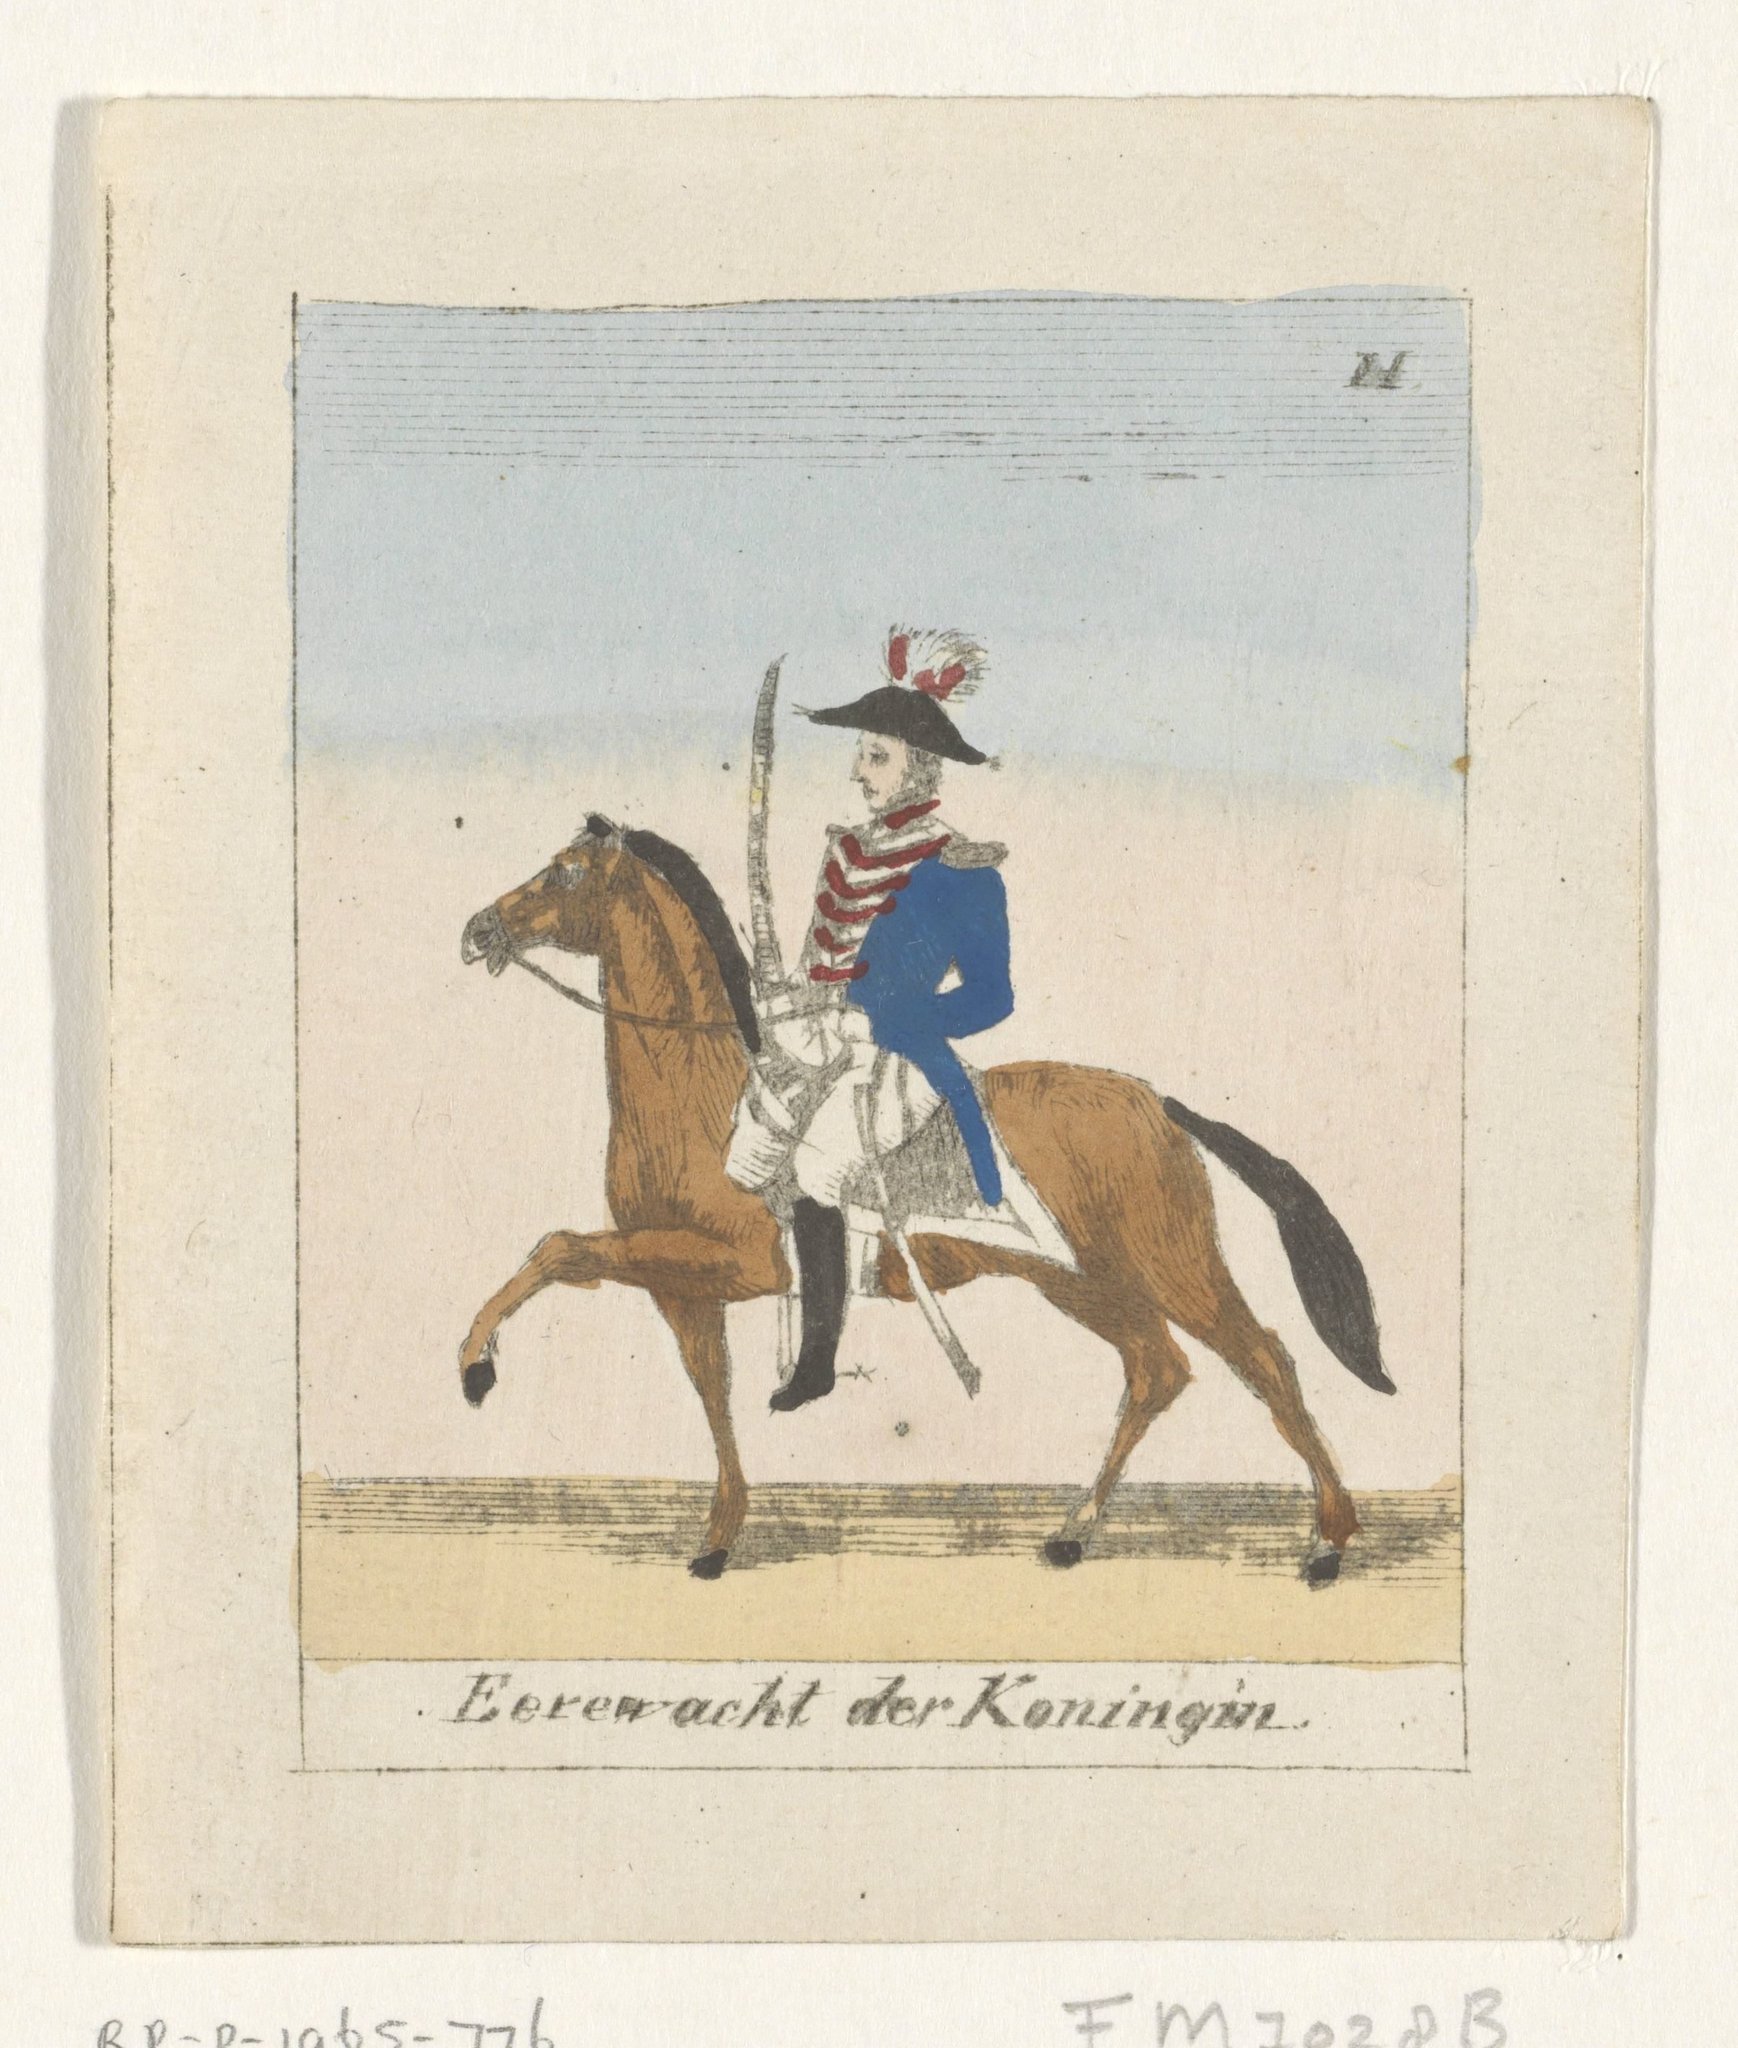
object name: print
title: Eerewacht der Koningin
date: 1840-1841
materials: paper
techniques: hand coloring, lithograph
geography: amsterdam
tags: william ii of the netherlands, other forms of installation, guard of honour, amsterdam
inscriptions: collector's mark: Lugt 2228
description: Erewacht van de koningin, een ruiter met getrokken sabel. Onderdeel van mapje met een serie van twaalf prentjes van de intocht van Willem II, de erepoorten opgericht in de stad en de inhuldiging op 28 november 1840 in de Nieuwe Kerk te Amsterdam.